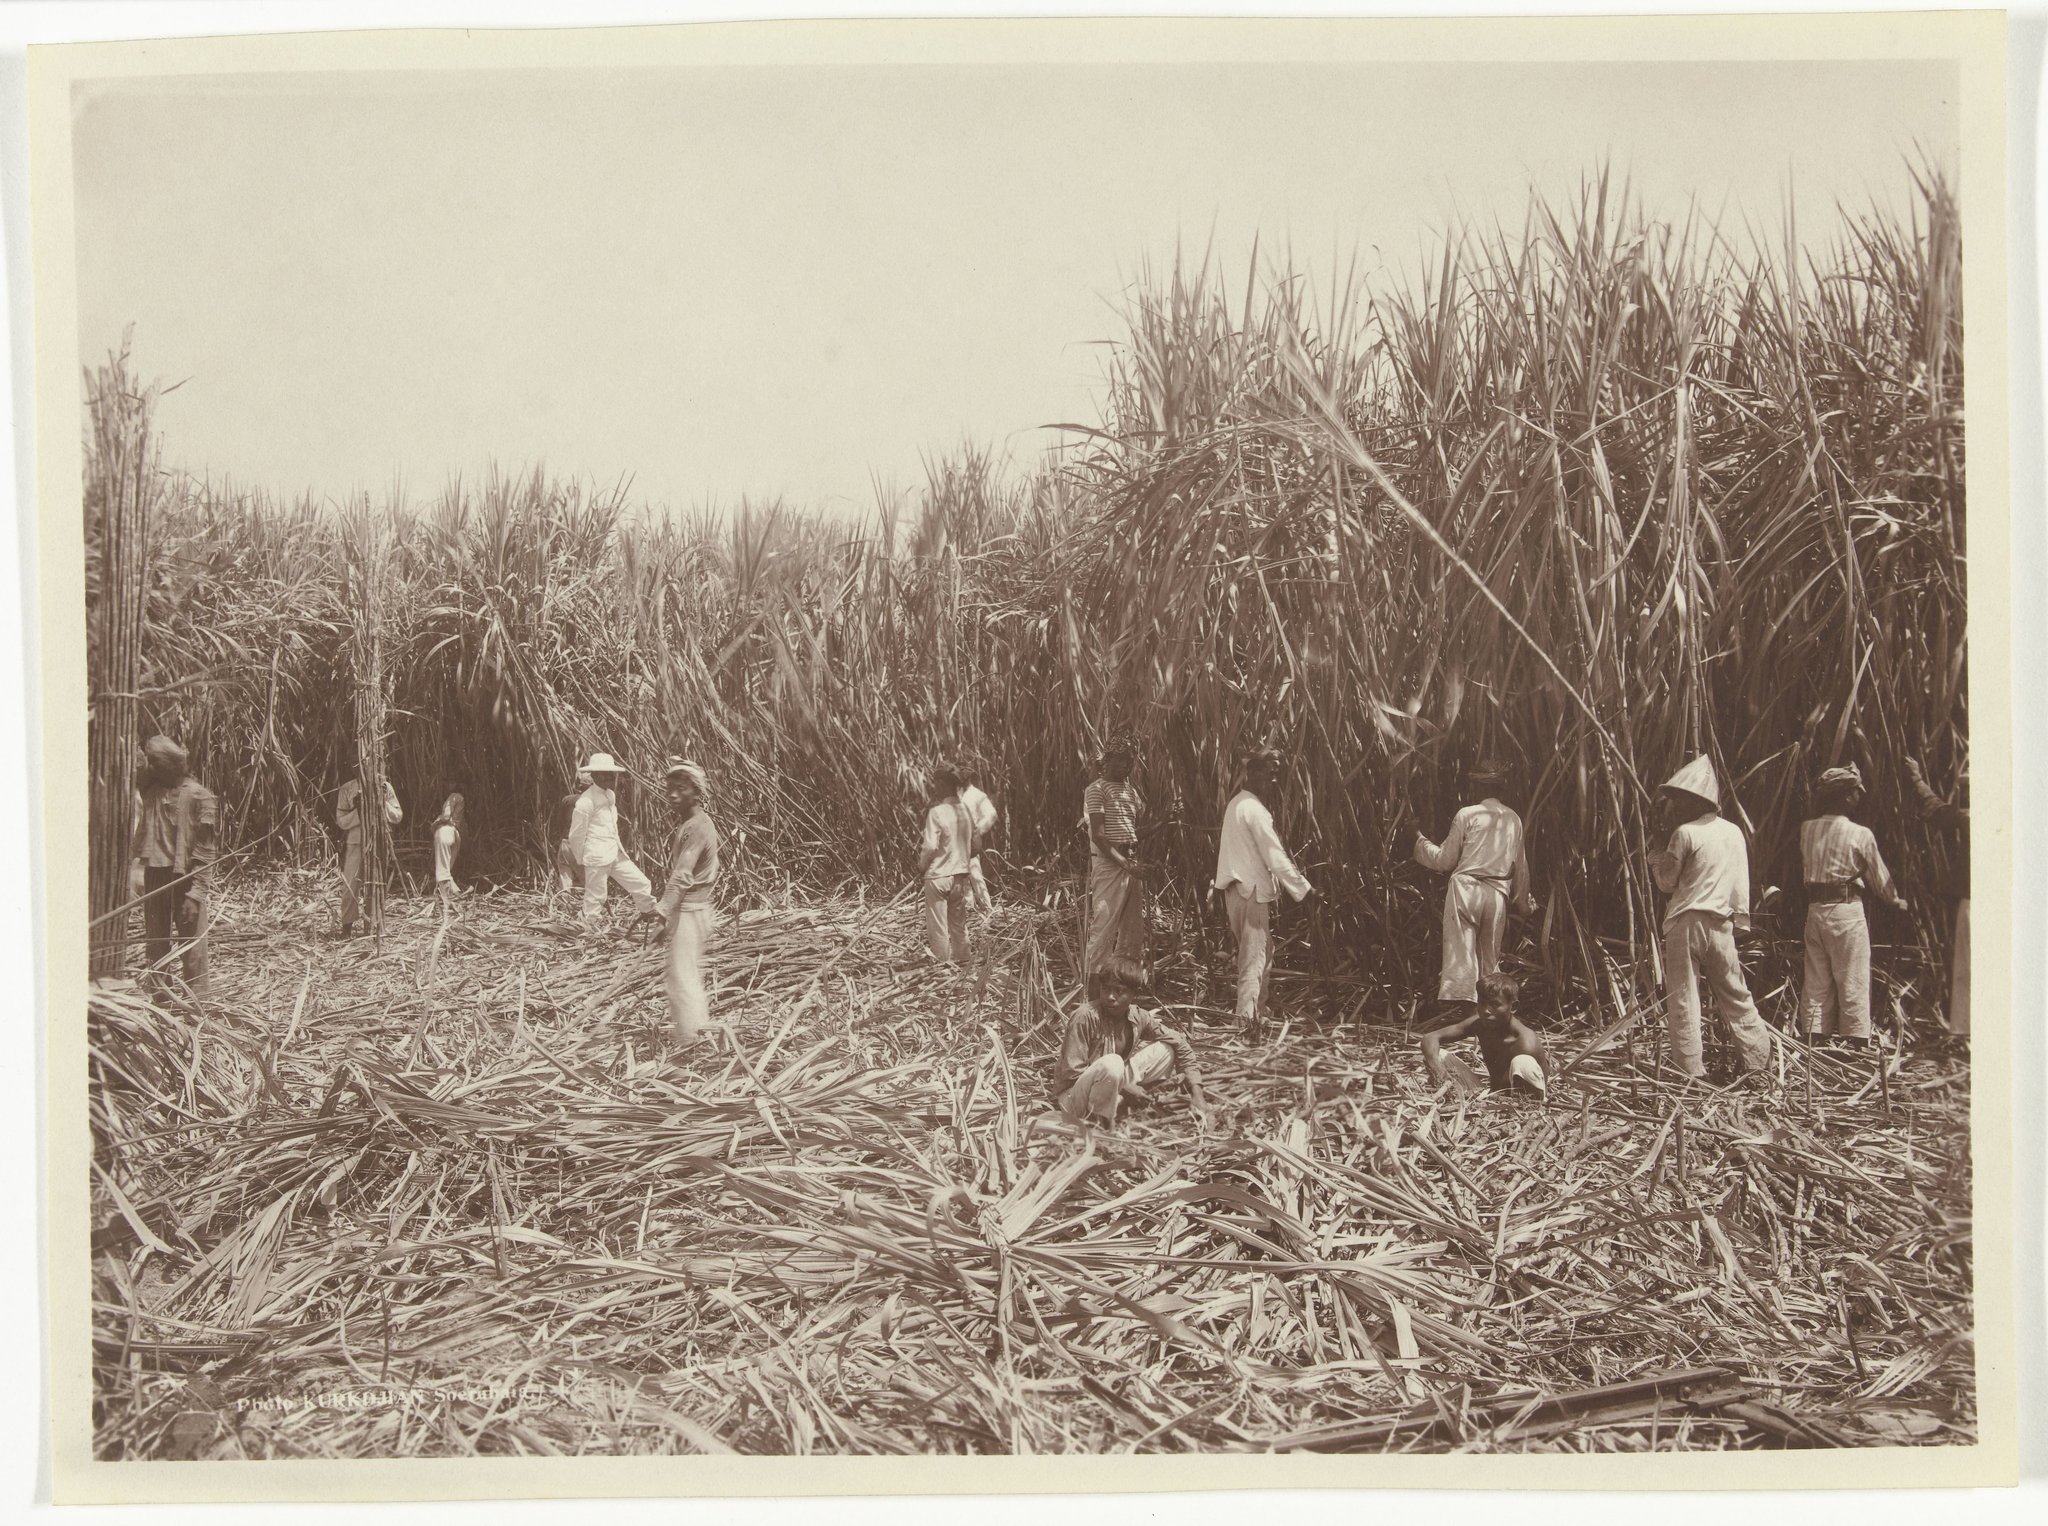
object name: photograph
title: Rietoogst, voormalig Nederlands-Indië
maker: onnes kurkdjian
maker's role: fotograaf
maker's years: 1851-1903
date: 1890-1911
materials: paper, photographic support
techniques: gelatin silver print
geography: surabaya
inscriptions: name: ‘Photo Kurkdjian Soerabaia’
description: Mannen zijn bezig met het oogsten van riet, voormalig Nederlands-Indië